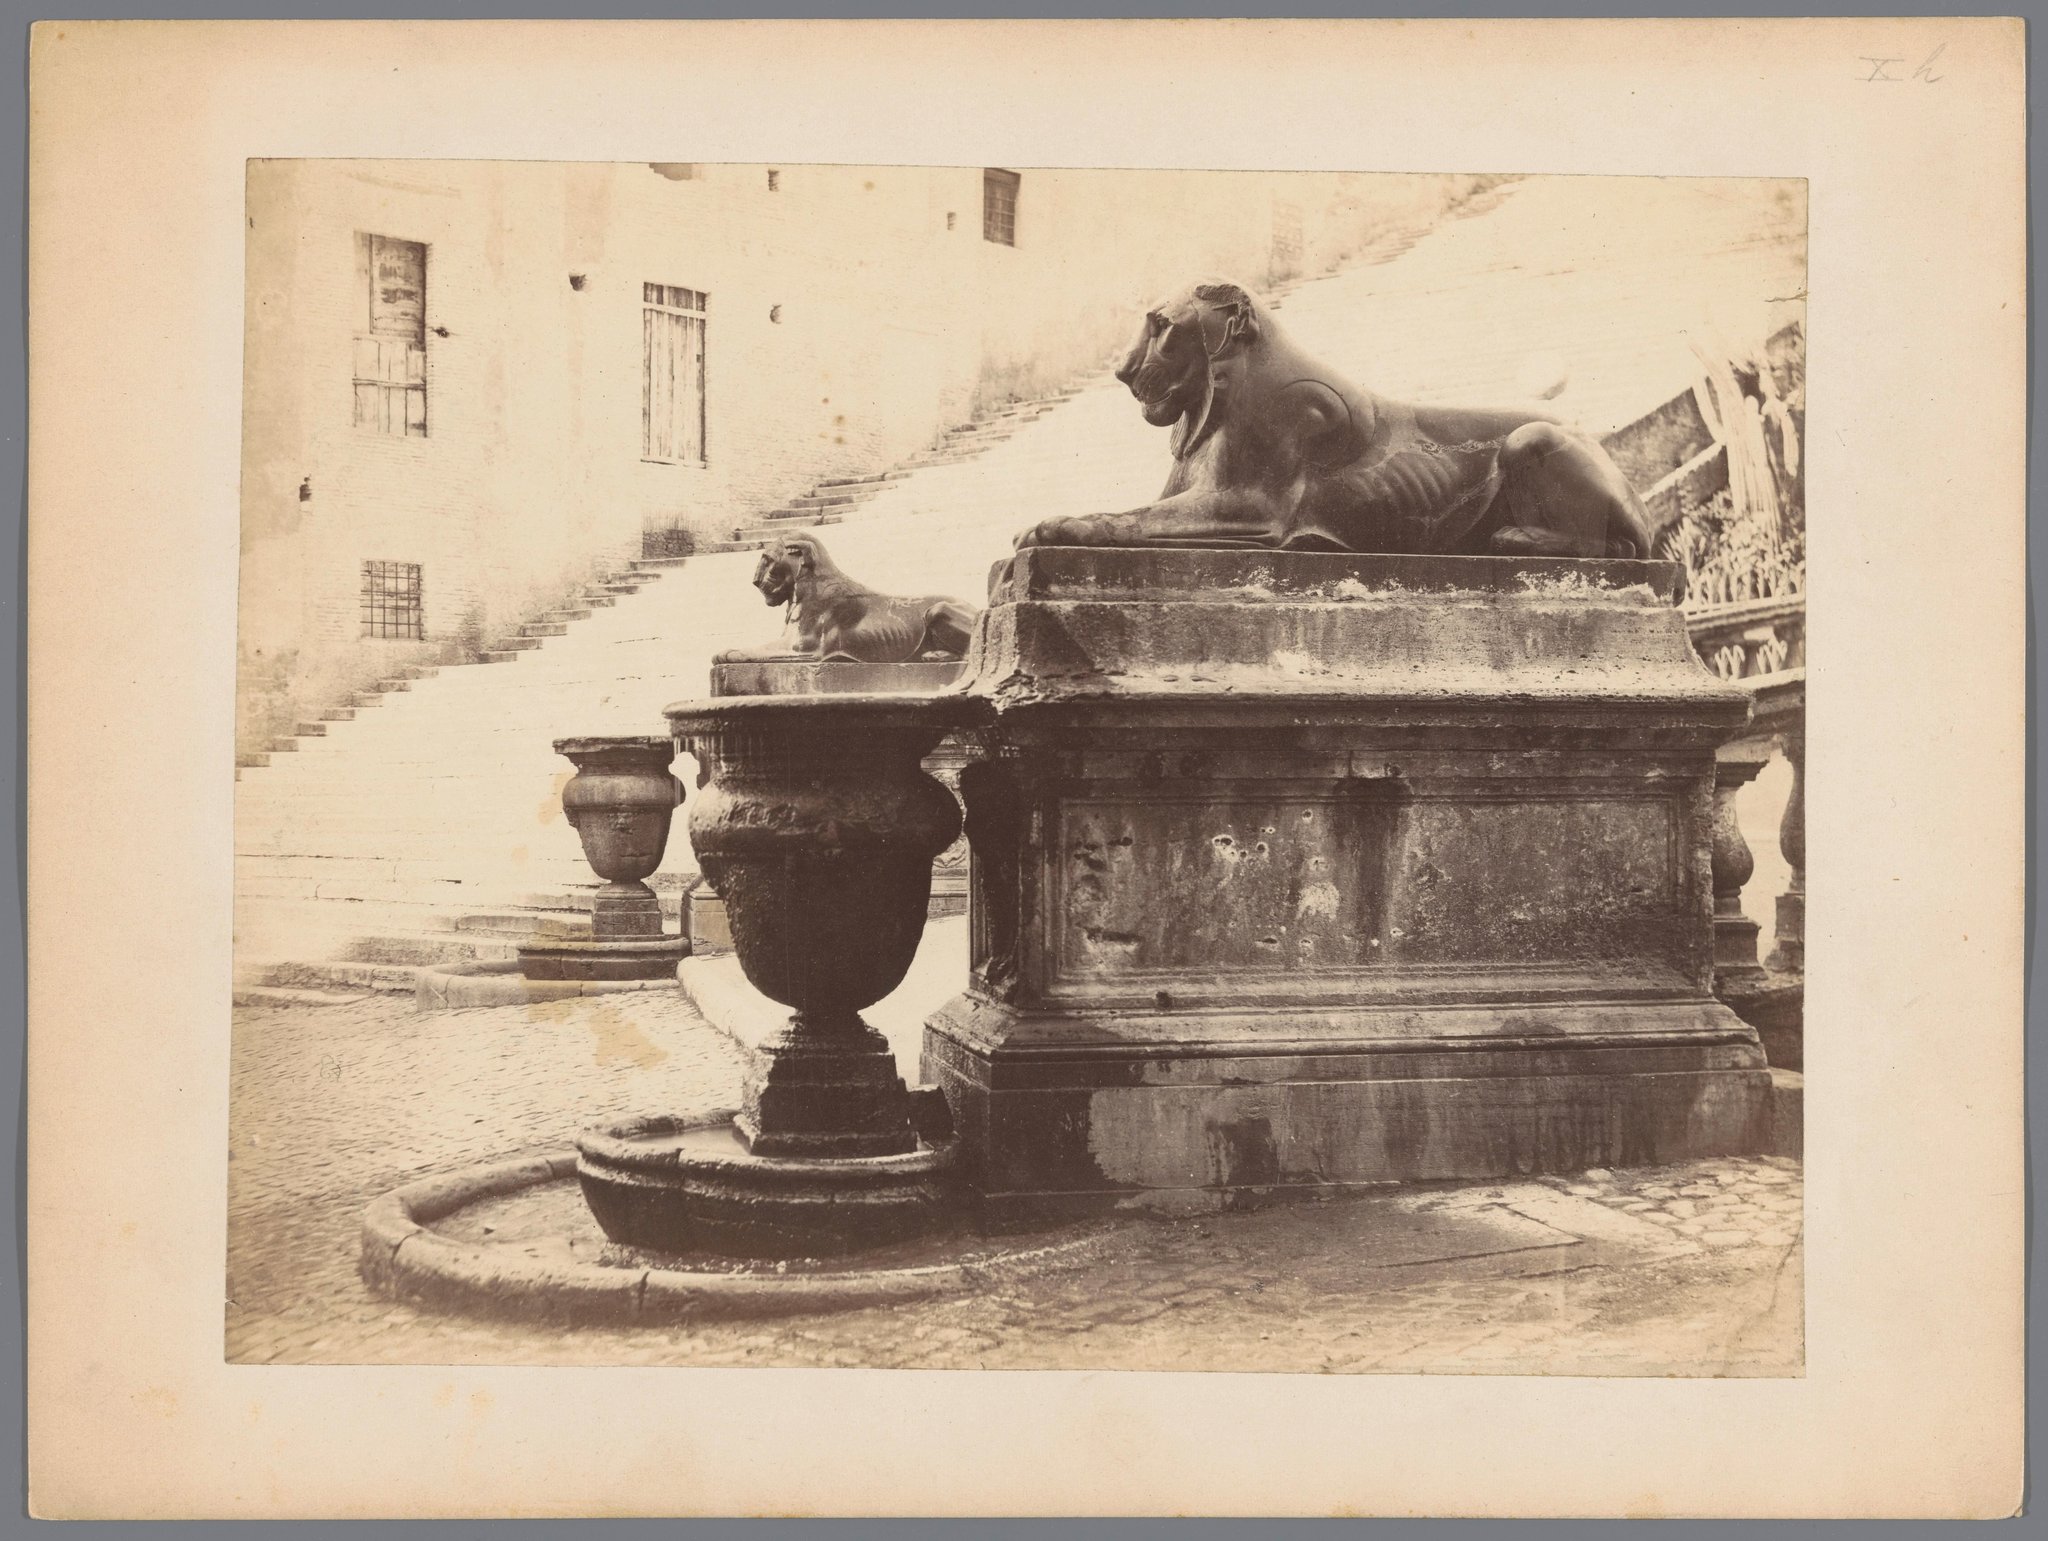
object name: photograph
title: Leeuwenbeelden op de trap naar het Piazza del Campidoglio te Rome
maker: a. de bonis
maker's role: fotograaf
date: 1855-1860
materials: photographic support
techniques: albumen print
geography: rome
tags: sculpture, beasts of prey, predatory animals: lion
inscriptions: collector's mark: Lugt 3937